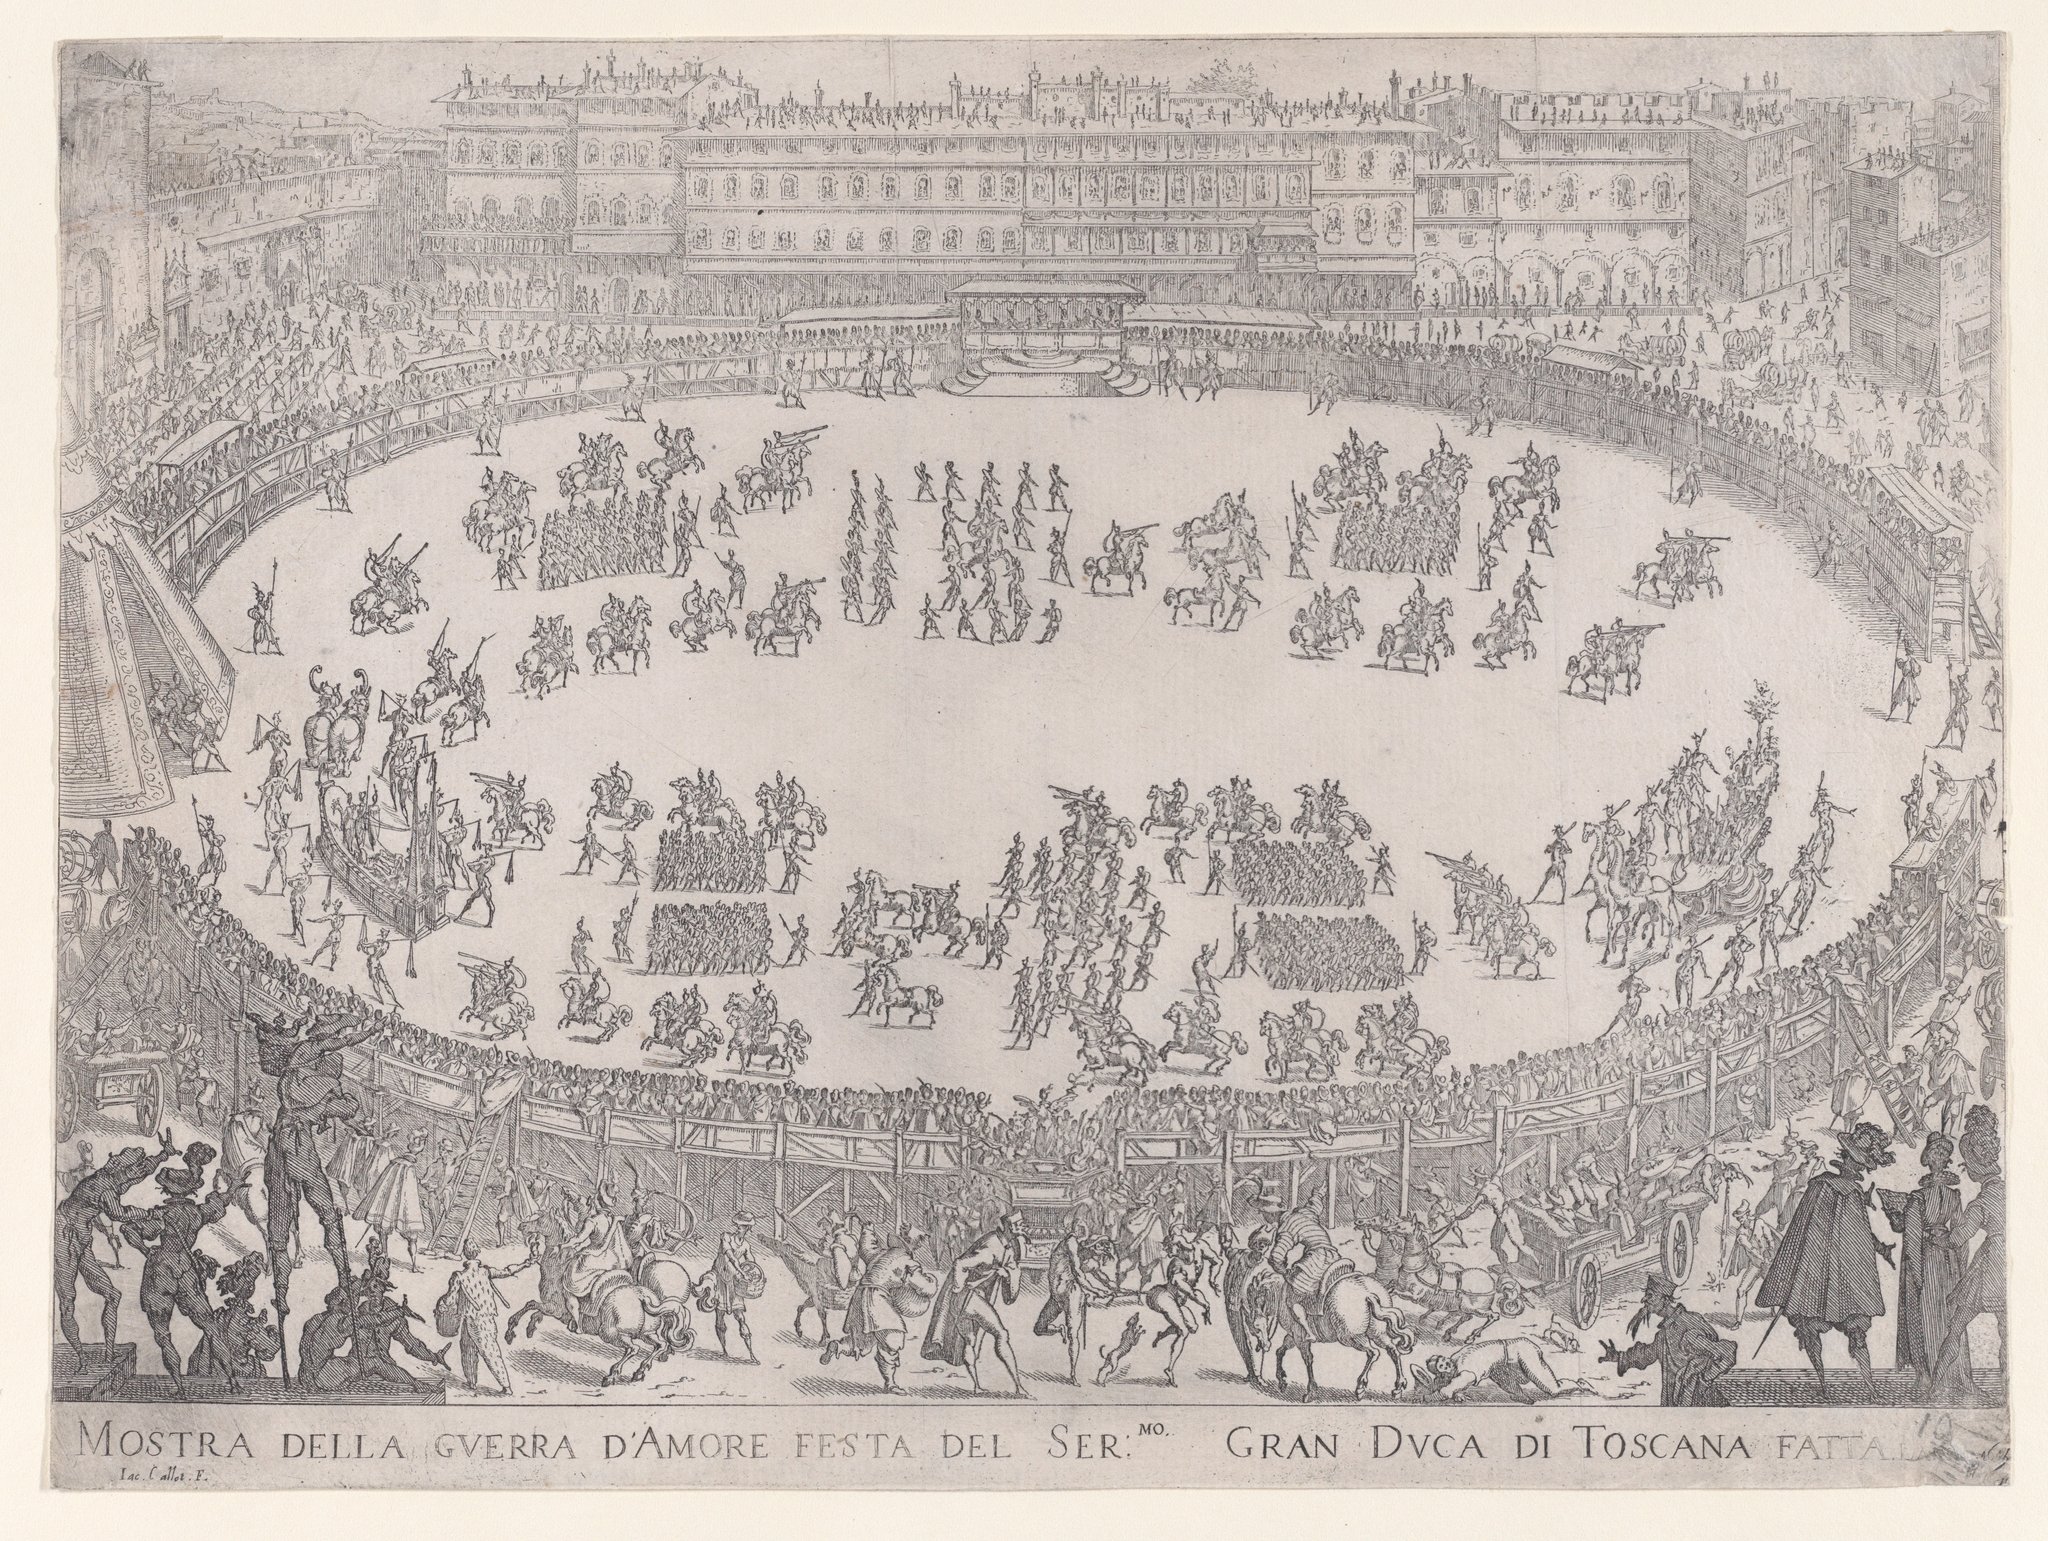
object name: print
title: Le Défilé Entrée des Chars de l'Afrique et de l'Aise (The Entrance Parade of the Chariots of Africa and Asia), from "La Guerre d'Amour" (Guerra d'Amore) (War of Love)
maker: jacques callot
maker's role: artist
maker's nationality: french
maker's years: 1592-1635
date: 1615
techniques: etching